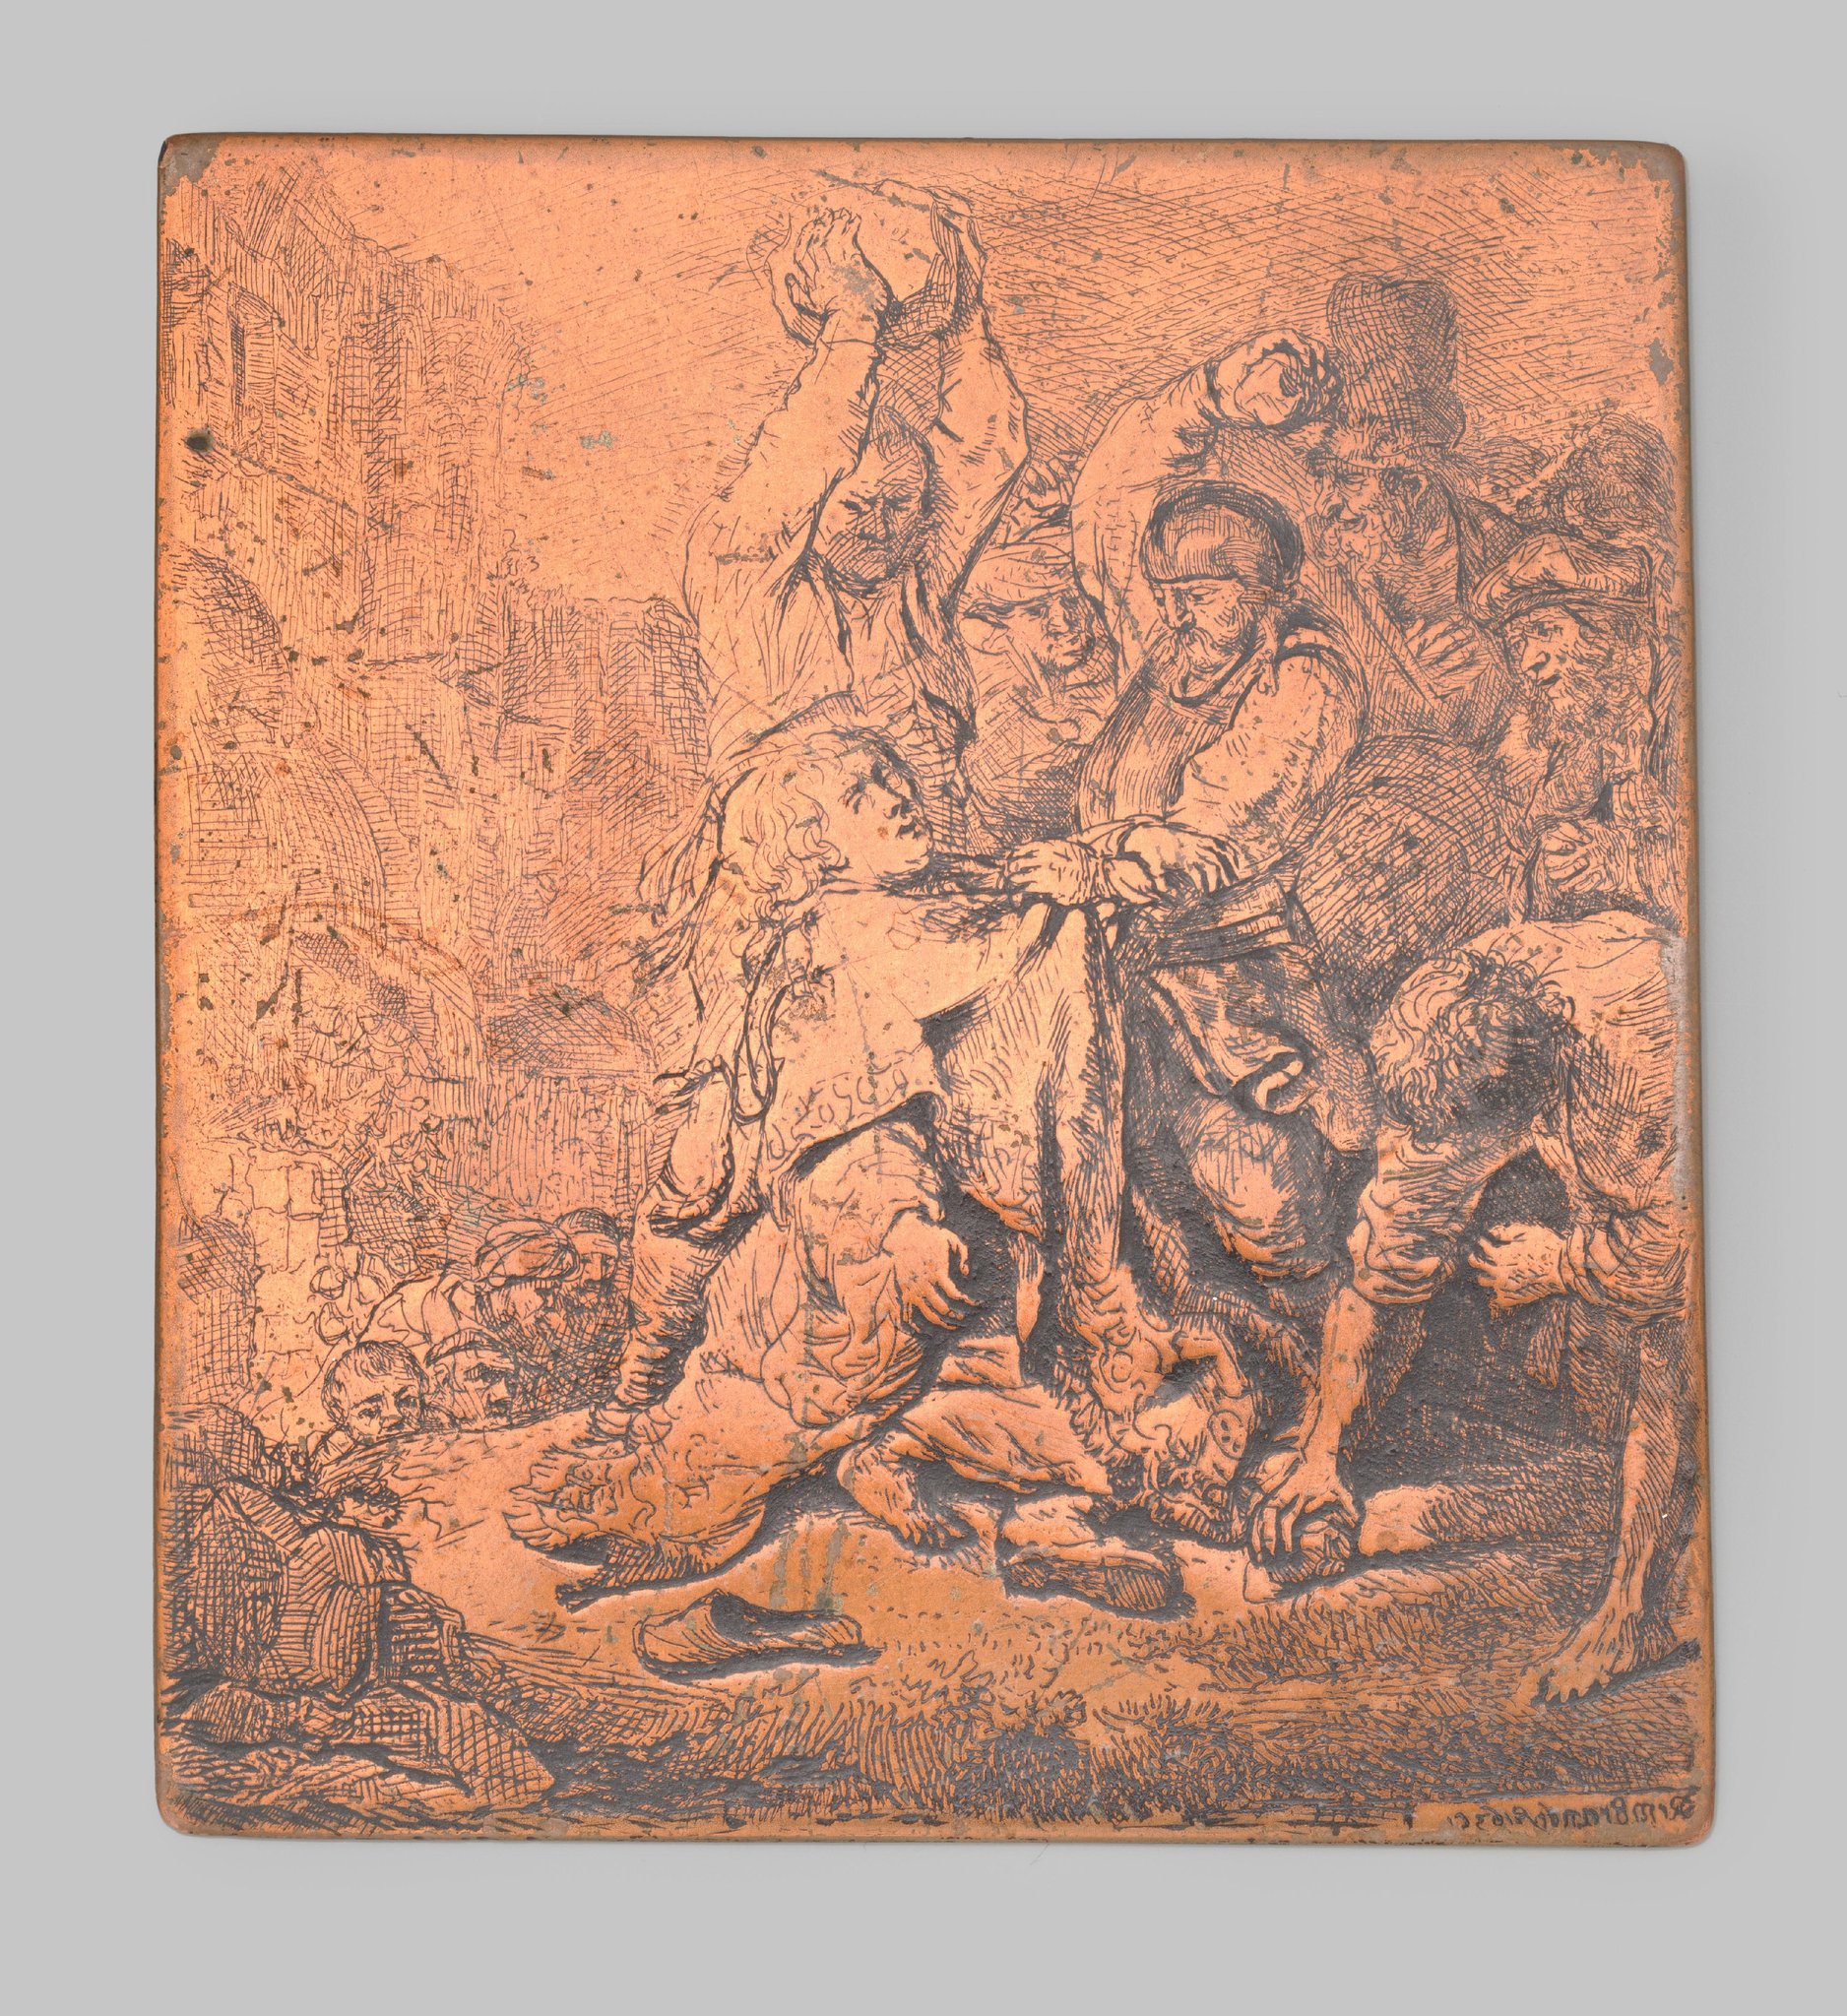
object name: copper plate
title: The Stoning of Stephen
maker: rembrandt van rijn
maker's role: draughtsman, painter, print maker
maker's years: 1606-1669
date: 1635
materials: copper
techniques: etching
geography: amsterdam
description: The image on Rembrandt’s copper plate is in reverse with respect to the prints, the unavoidable outcome of the printing process. Rembrandt did not seem to take this into account beforehand, although he did inscribe his name in reverse on the plate. This copper plate offers a pure picture of how he initially conceived the composition. Here Stephen appears even more prominently as the centre of the composition than in the etching.